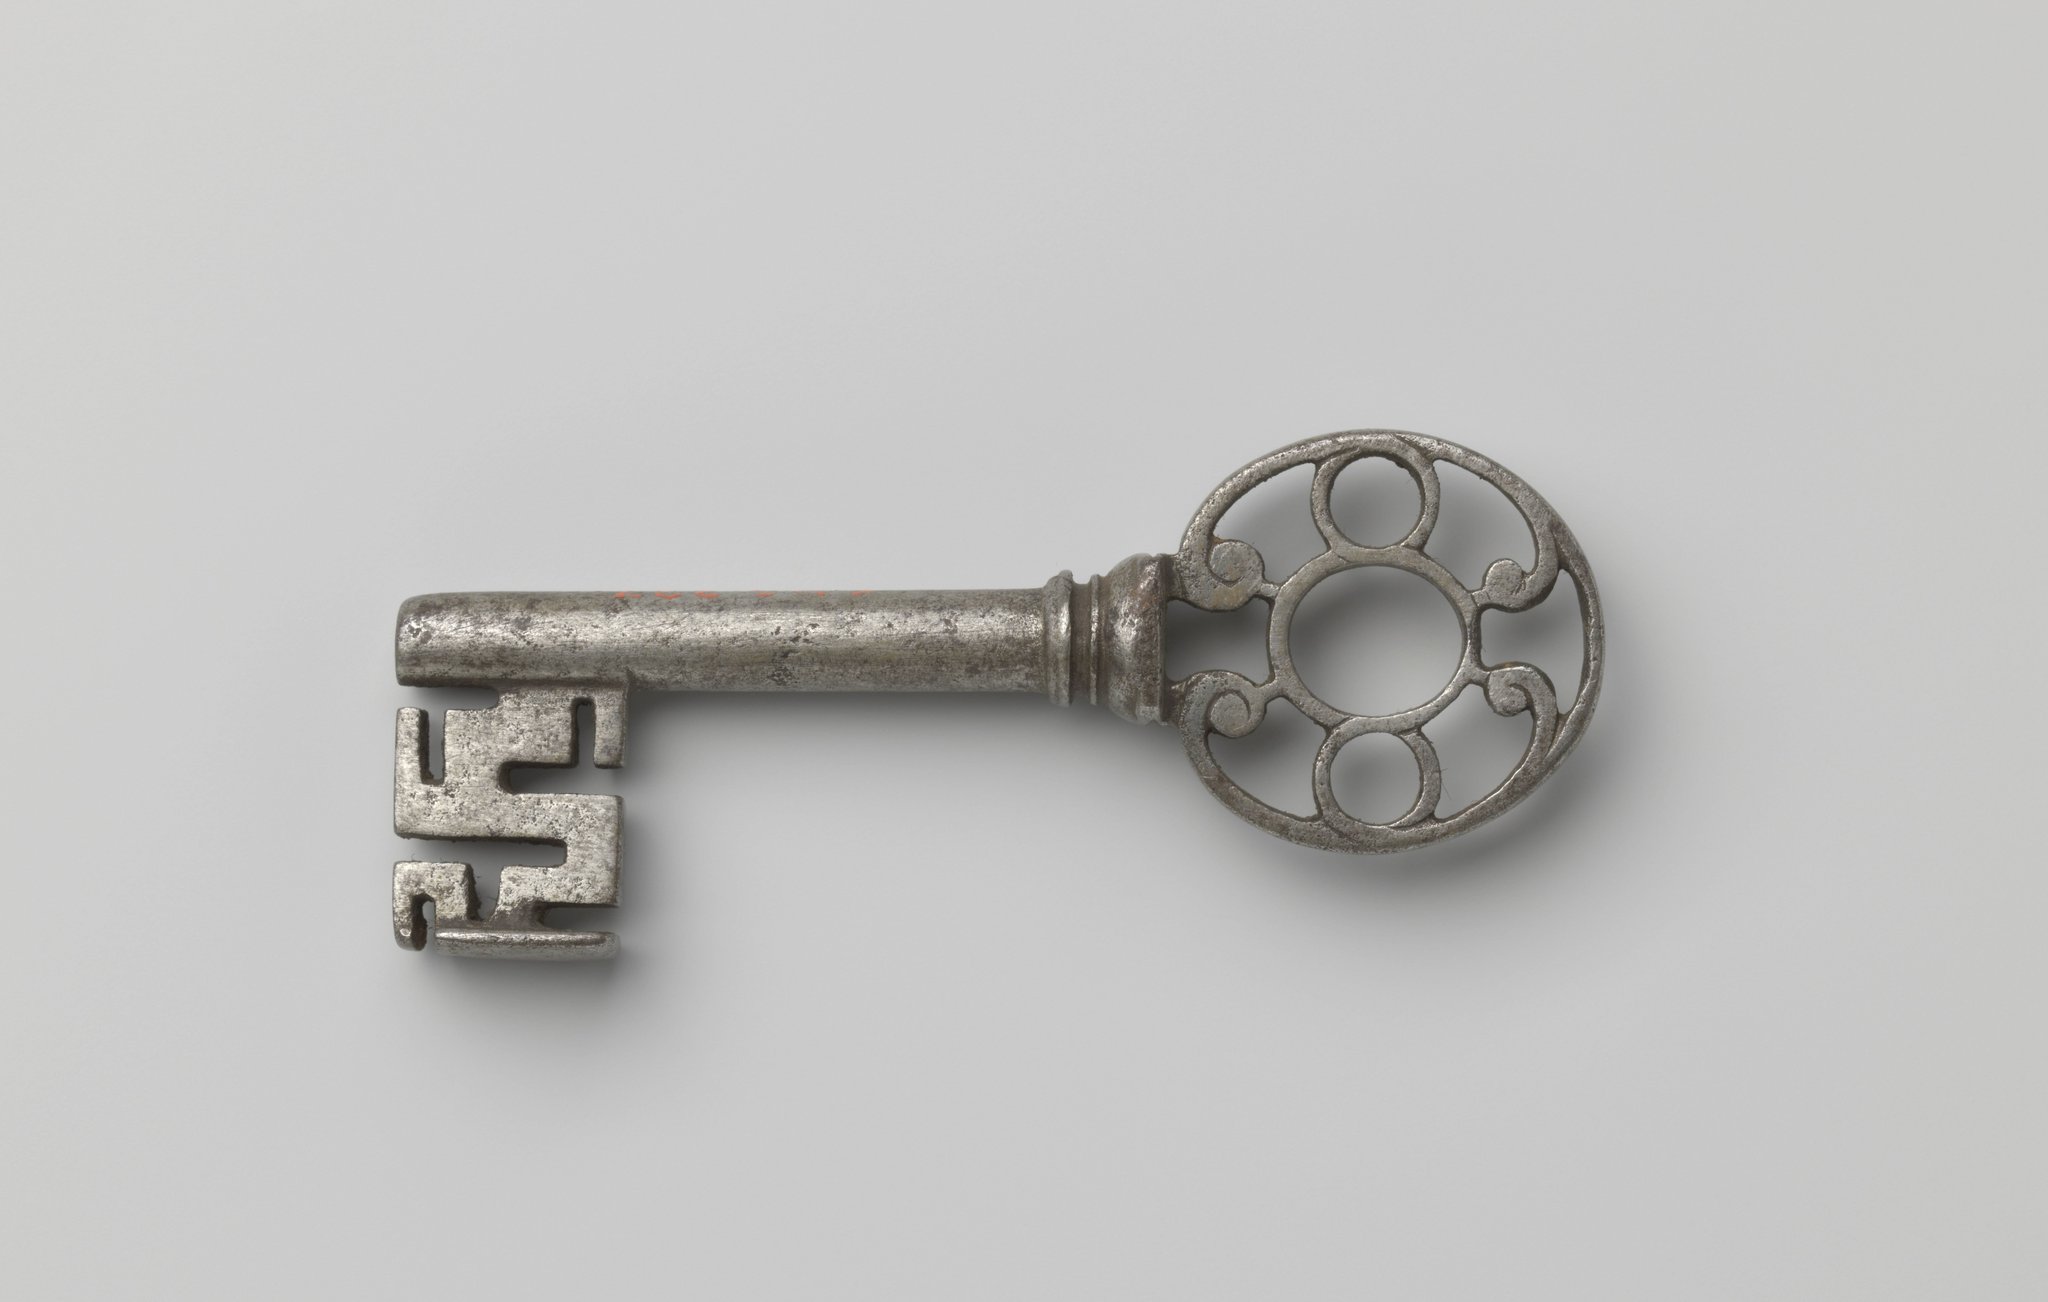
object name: pipe key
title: Pijpsleutel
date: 1575-1600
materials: iron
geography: france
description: Pijpsleutel met Dorisch kapiteel. Hierop rust de cirkelvormige greep die uit twee C-voluten en daarin beslote ringen samengesteld is.